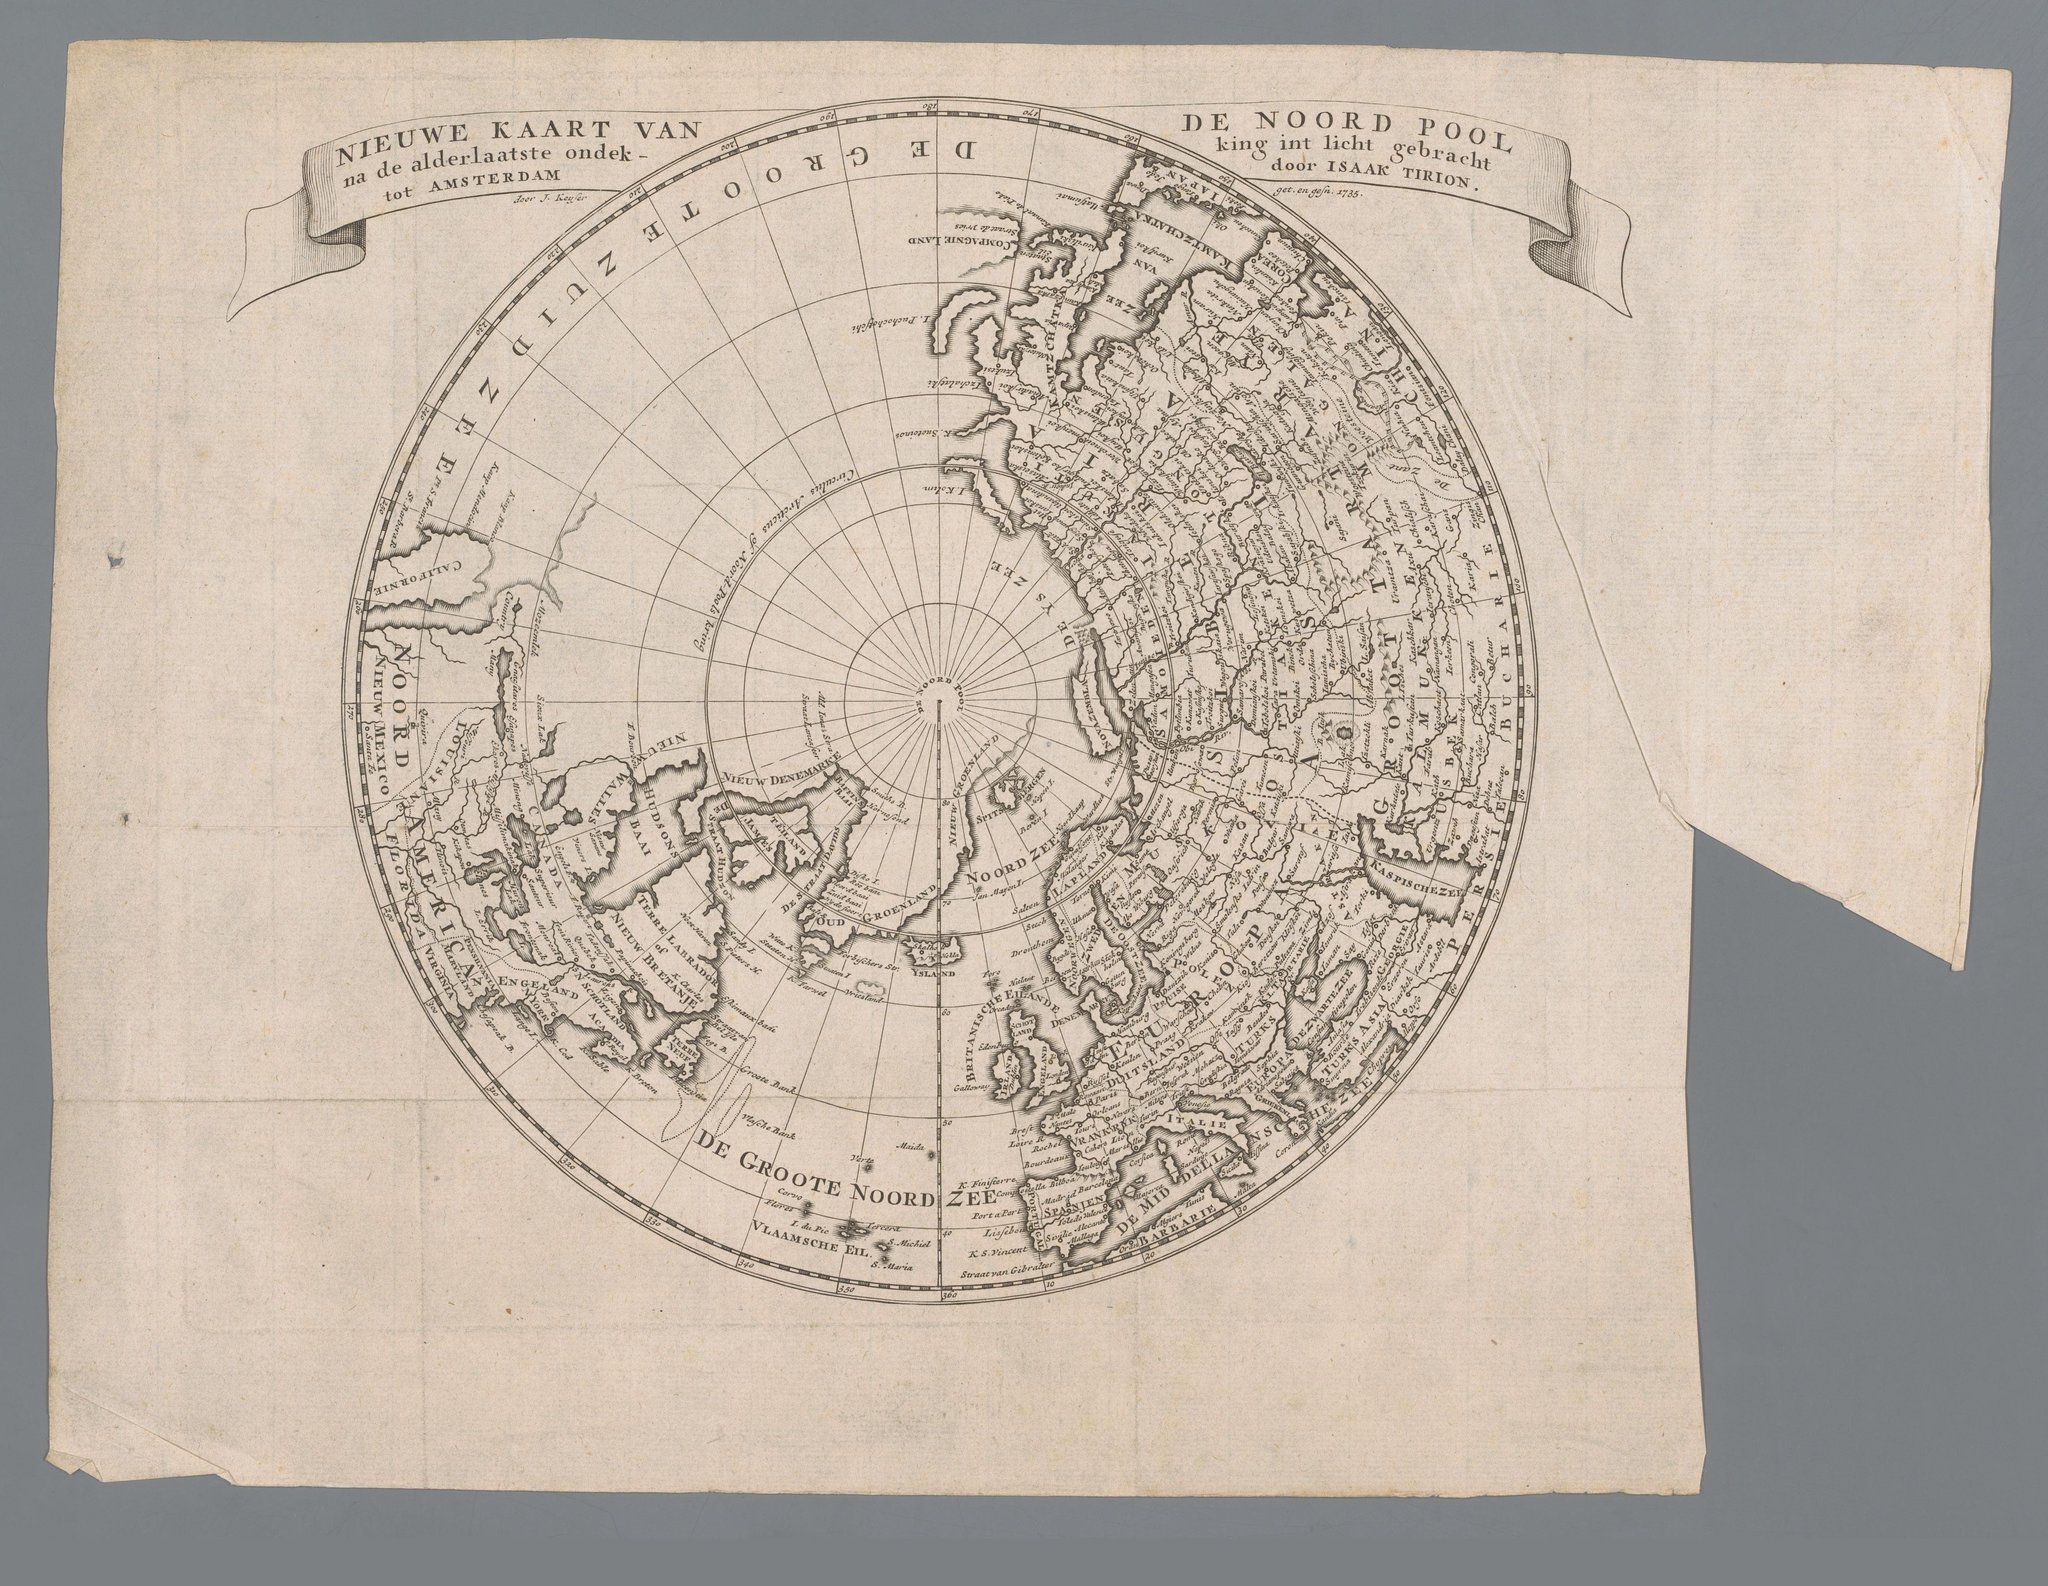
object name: map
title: Kaart van de Noordpool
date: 1735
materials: paper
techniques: engraving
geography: amsterdam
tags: (map of) the polar regions, frigid zones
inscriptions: date